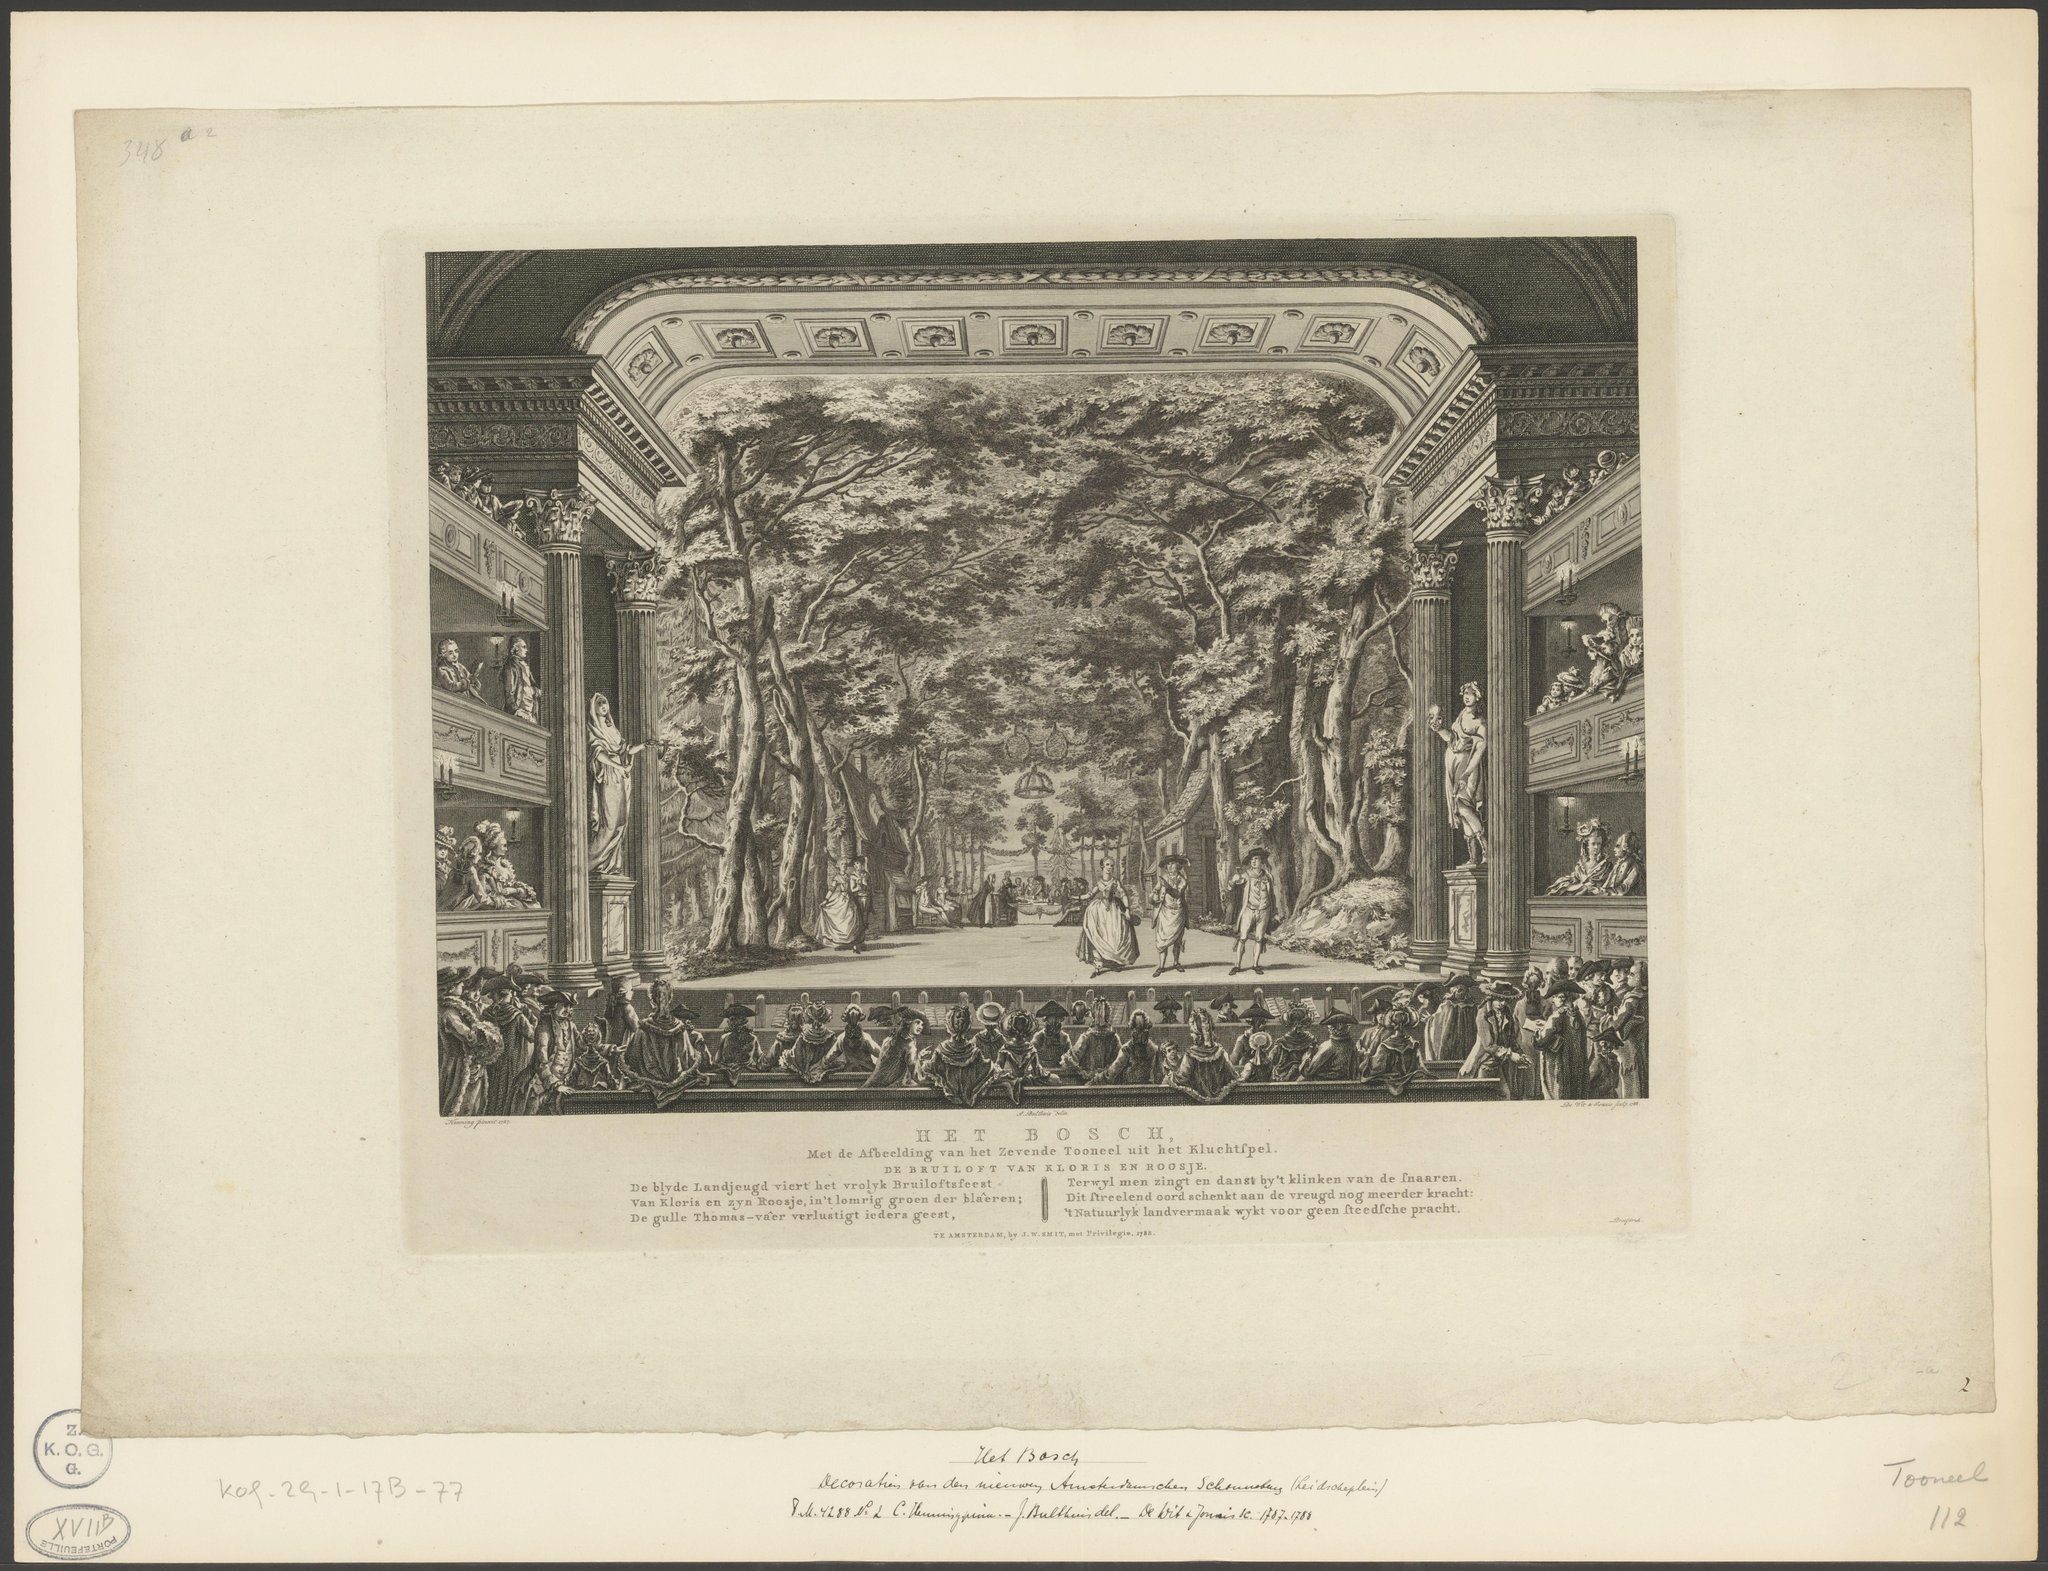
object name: print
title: Het Bosch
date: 1788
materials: paper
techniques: engraving, etching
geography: amsterdam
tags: theatre, theatrical performance, stage design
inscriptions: stamp, collector's mark: Lugt 1641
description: Toneelvoorstelling in de nieuwe Amsterdamse Schouwburg met het coulissendecor Het Bosch, met scène uit De Bruiloft van Kloris en Roosje. Het decor gedrukt van een aparte plaat binnen een passe-partout met de zaal, zijloges, pilaren met standbeelden en de façade van het toneel. In het onderschrift een zesregelig vers. Onderdeel van de serie van veertien toneeldecors van de nieuwe Amsterdamse Schouwburg, 1787-1794. Onderwerpsrubrieken binnen de Atlas Zeden en Gewoonten: Schoone kunsten, Tooneel, Decors voor de Schouwburg.